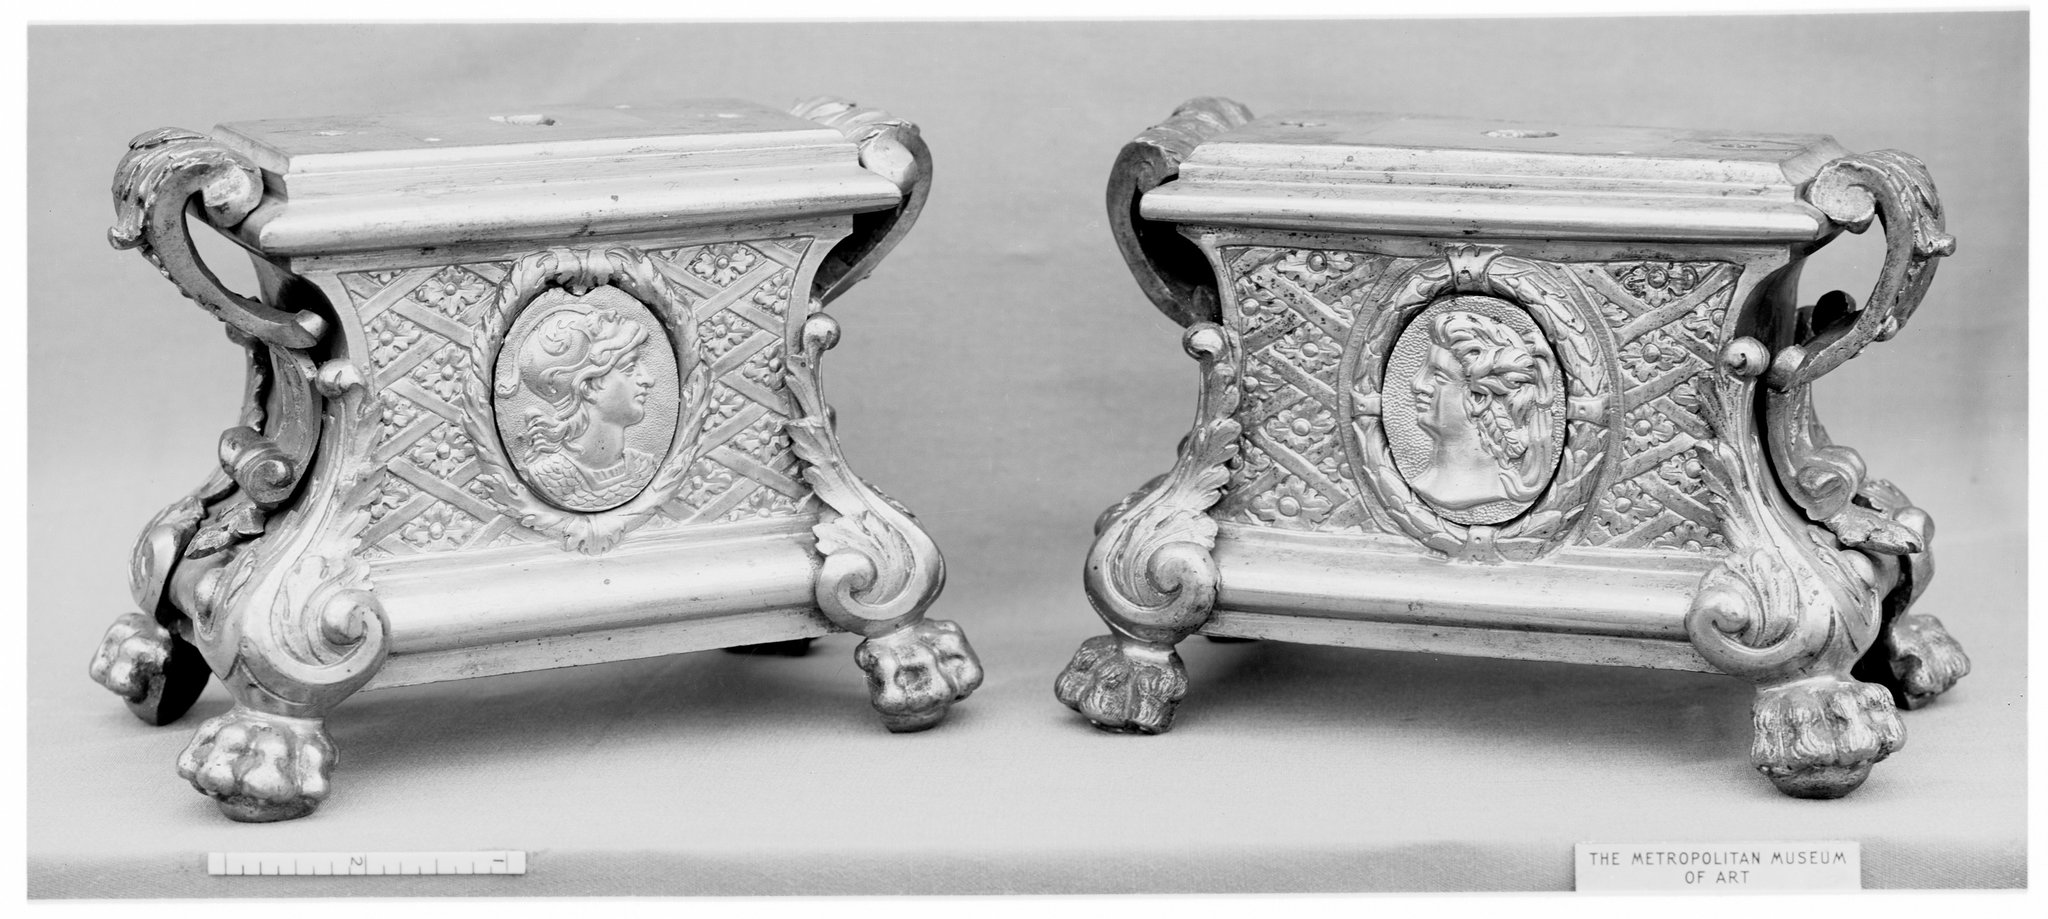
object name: pedestal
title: Pair of pedestals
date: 1701-1800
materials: gilt bronze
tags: men,profiles,women